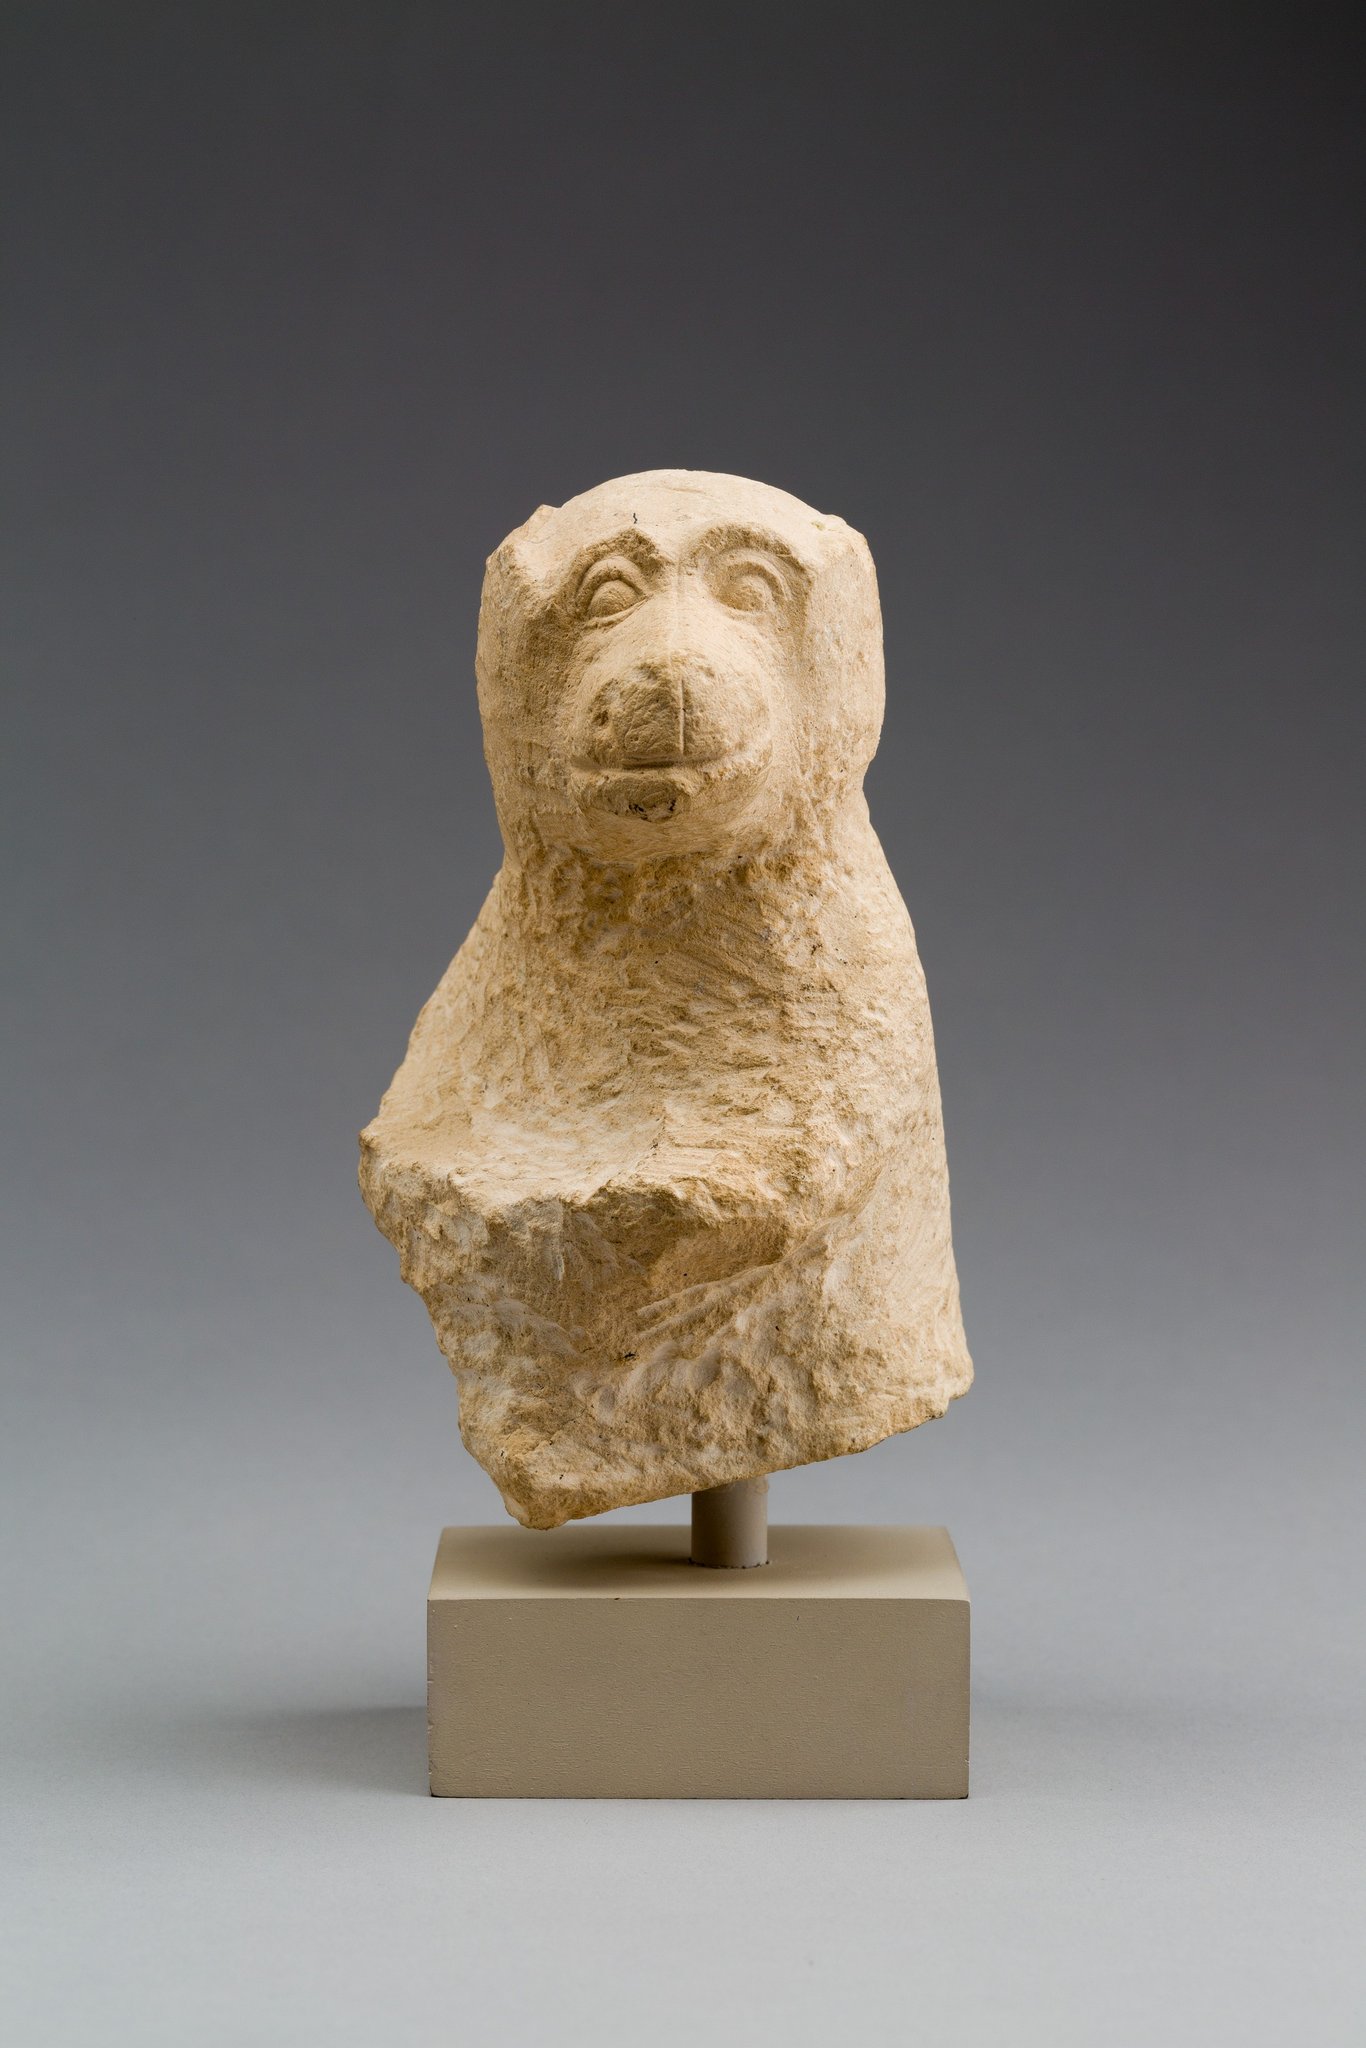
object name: figurine, monkey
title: Figure of monkey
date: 1981-1640 BCE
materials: limestone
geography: egypt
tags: monkeys